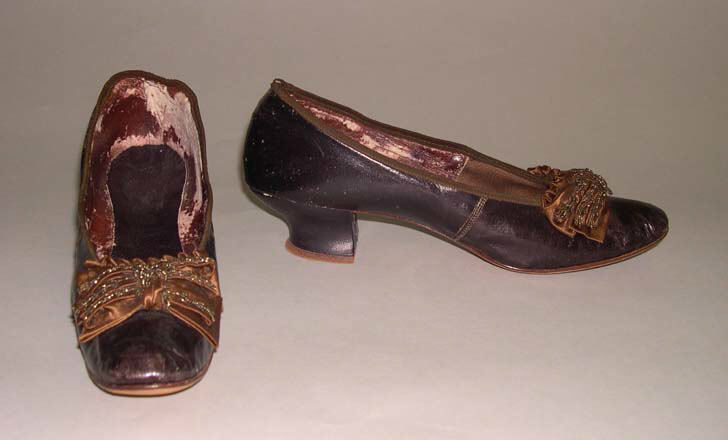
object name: slipper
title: Slippers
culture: american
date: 1880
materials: leather, silk